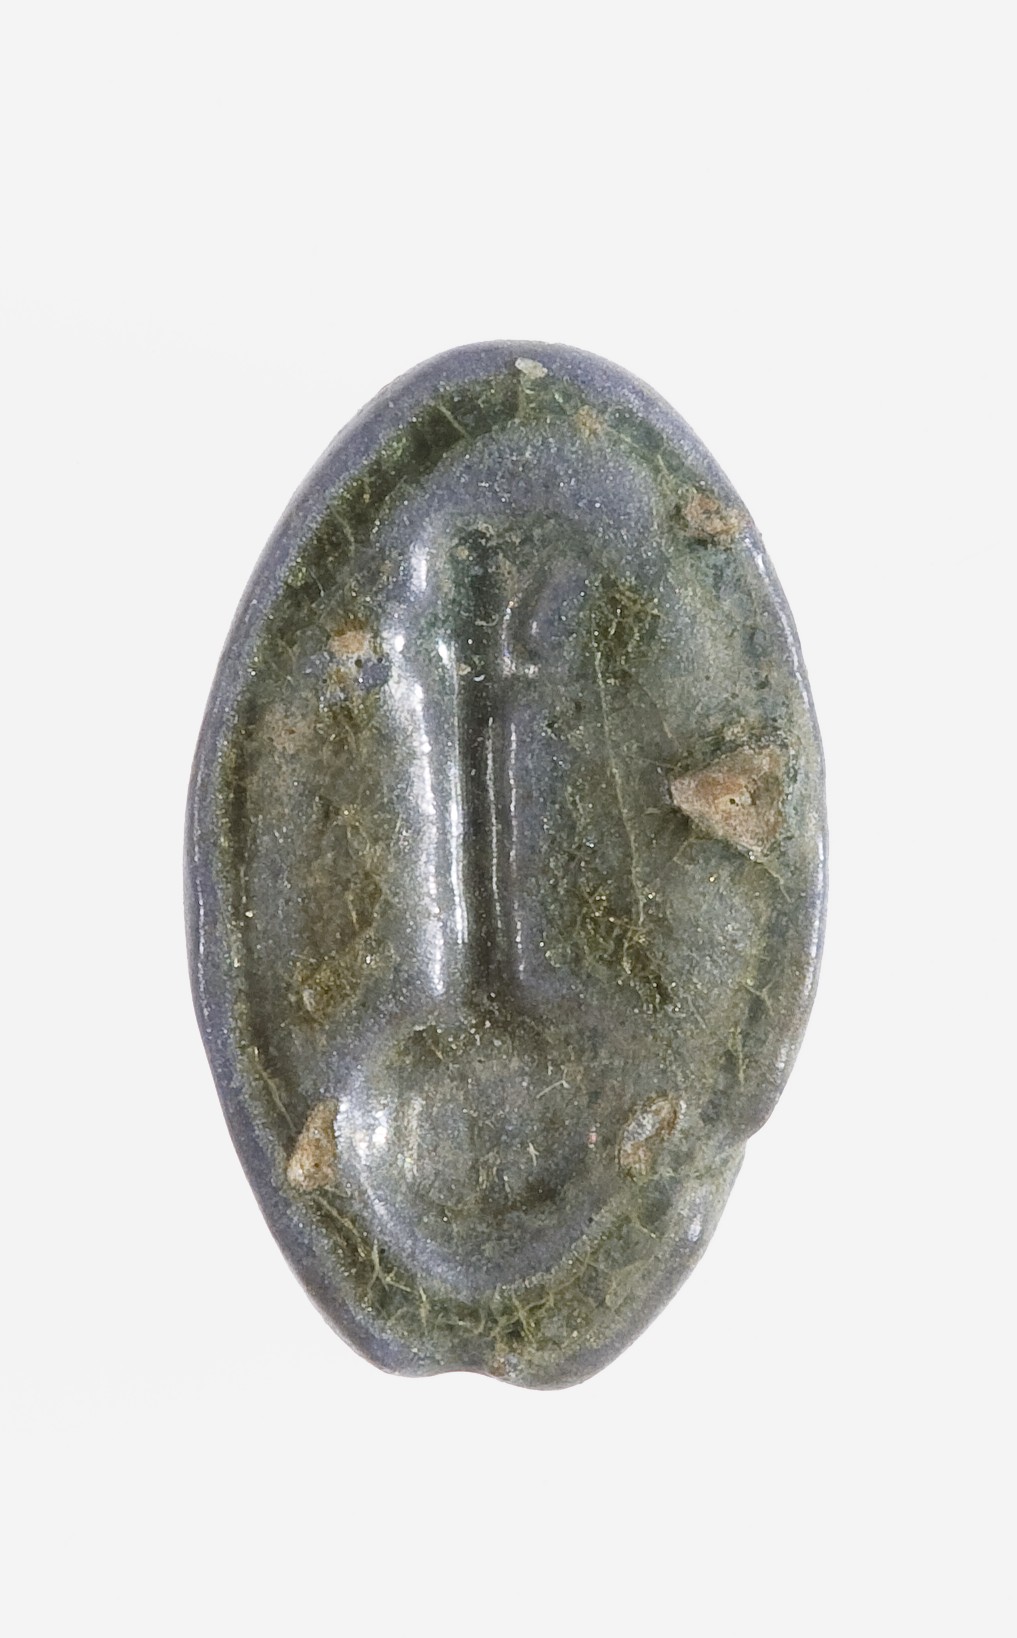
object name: cowroid, nefer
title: Cowroid Stamp Seal with a Nefer Hieroglyph on the Base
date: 1390-1352 BCE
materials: faience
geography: egypt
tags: hieroglyphs